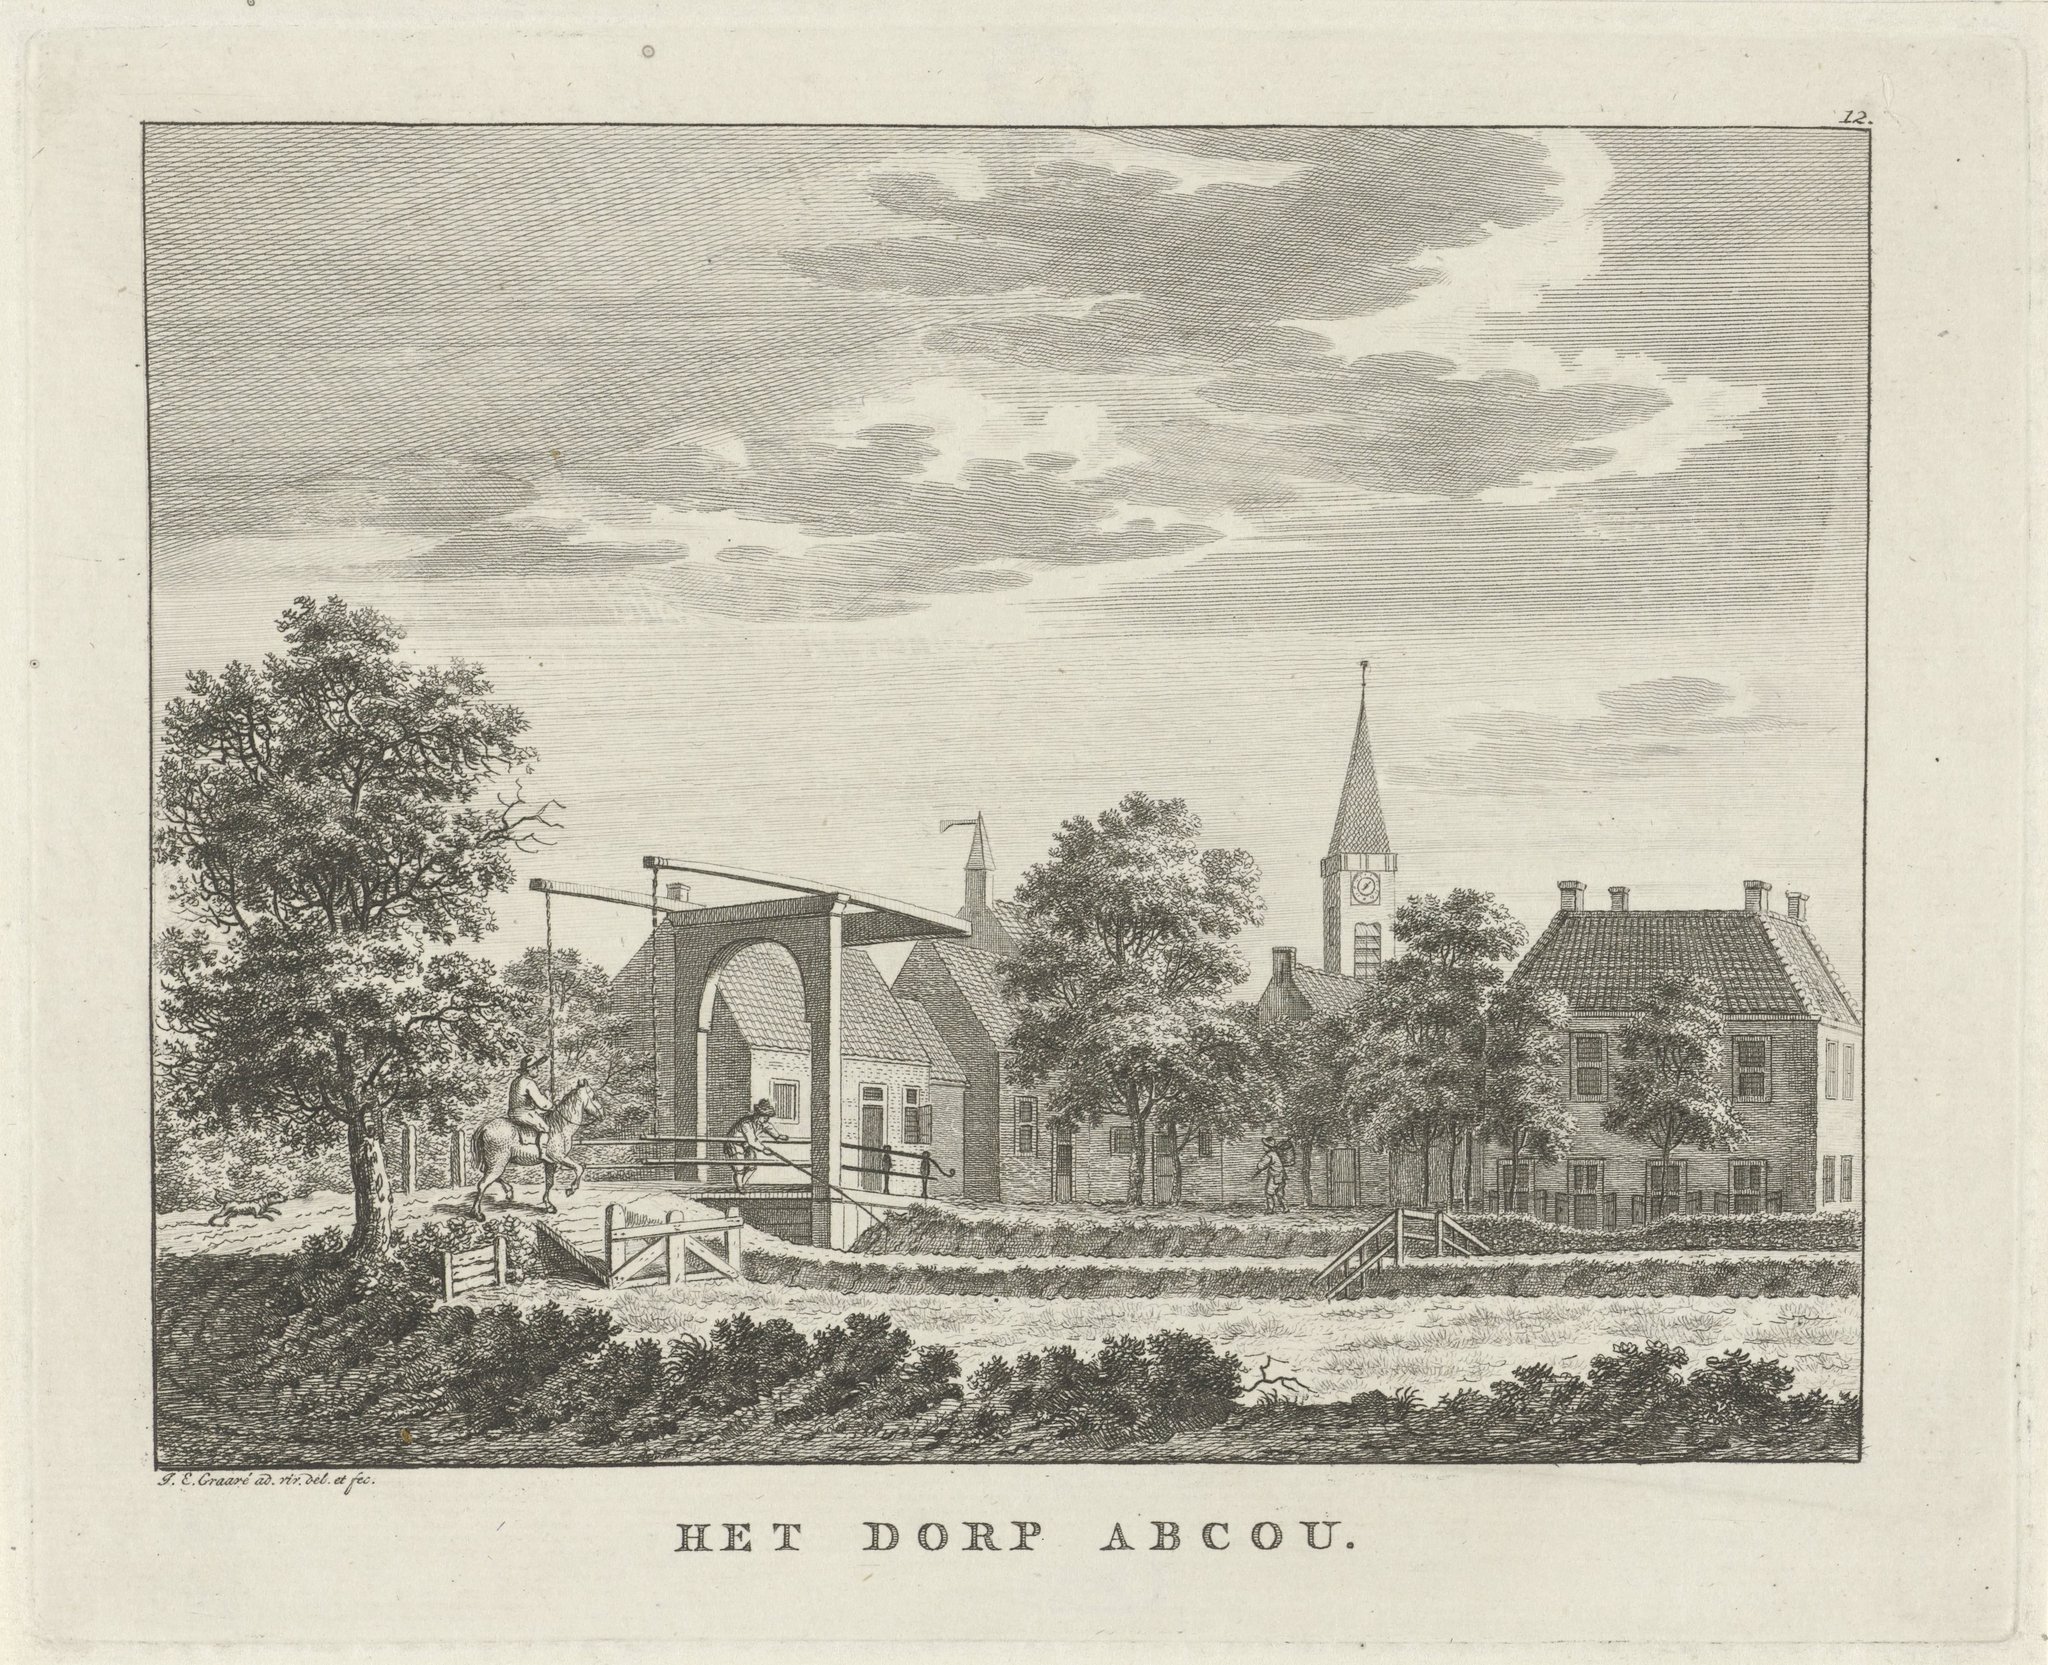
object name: print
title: Gezicht op het dorp Abcoude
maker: jan evert grave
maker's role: draughtsman, print maker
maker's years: 1759-1805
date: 1786-1805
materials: paper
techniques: engraving, etching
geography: amsterdam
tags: landscape with bridge, viaduct or aqueduct (+ city(-scape) with figures, staffage), abcoude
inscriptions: collector's mark: Lugt 2228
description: Het dorp Abcoude. Op de voorgrond een brug over een rivier. Op de achtergrond de kerktoren. De prent maakt deel uit van een serie met Nederlandse dorpen.